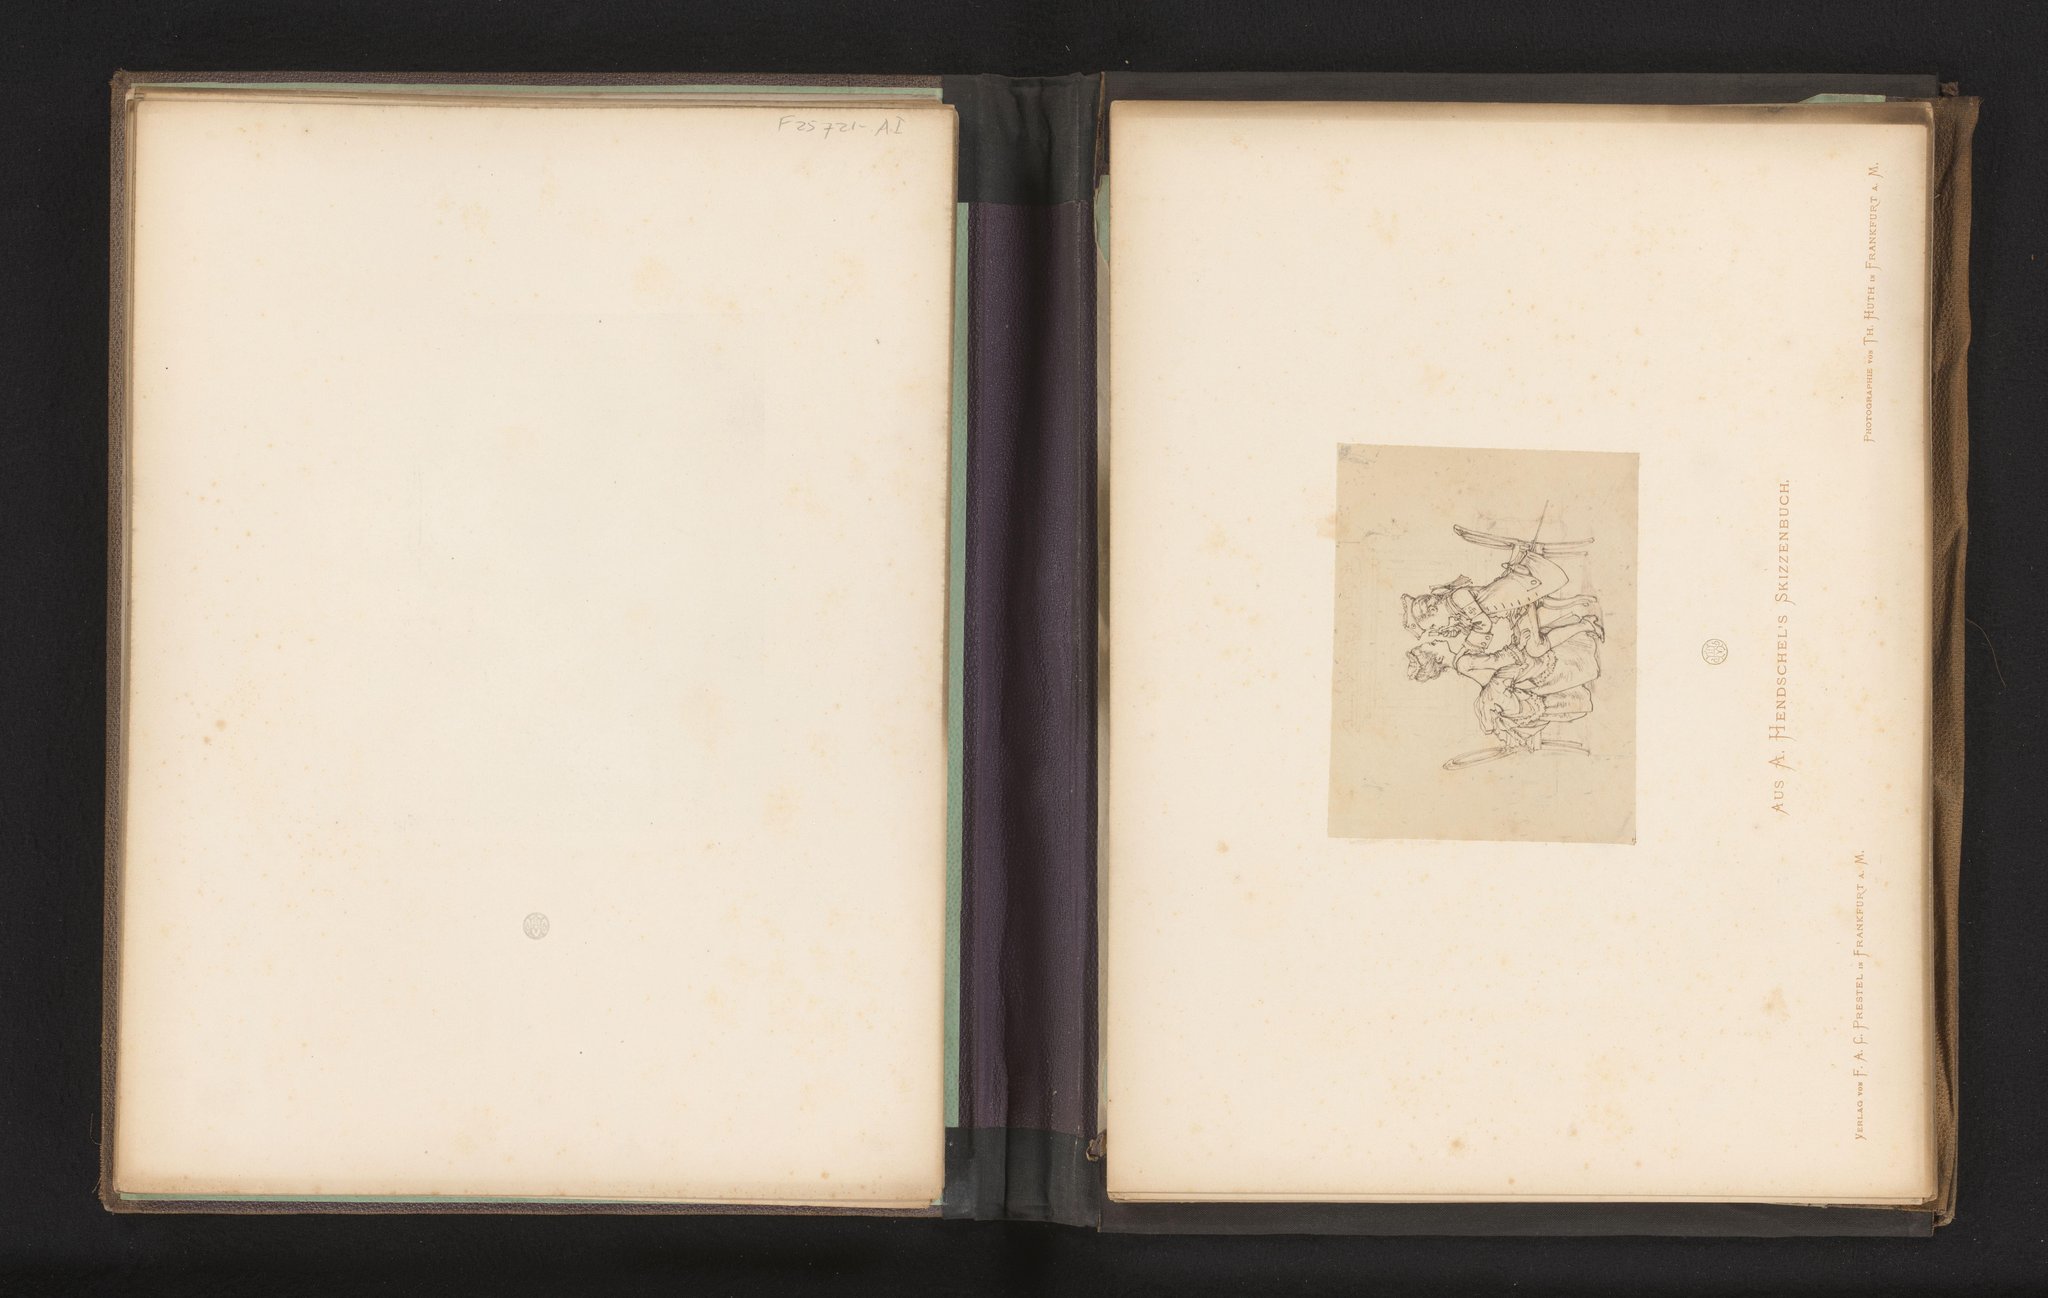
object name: reproduction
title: Fotoreproductie van een schets van twee kinderen die een bezoek aan de oogarts naspelen, door Albert Hendschel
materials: paper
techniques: albumen print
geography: frankfurt am main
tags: children's games and plays, child (+ two persons)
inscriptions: monogram: ‘AH’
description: Deze foto maakt deel uit van een omslag met 50 foto's op 48 bladen, een lijst van afbeeldingen en een titelblad.